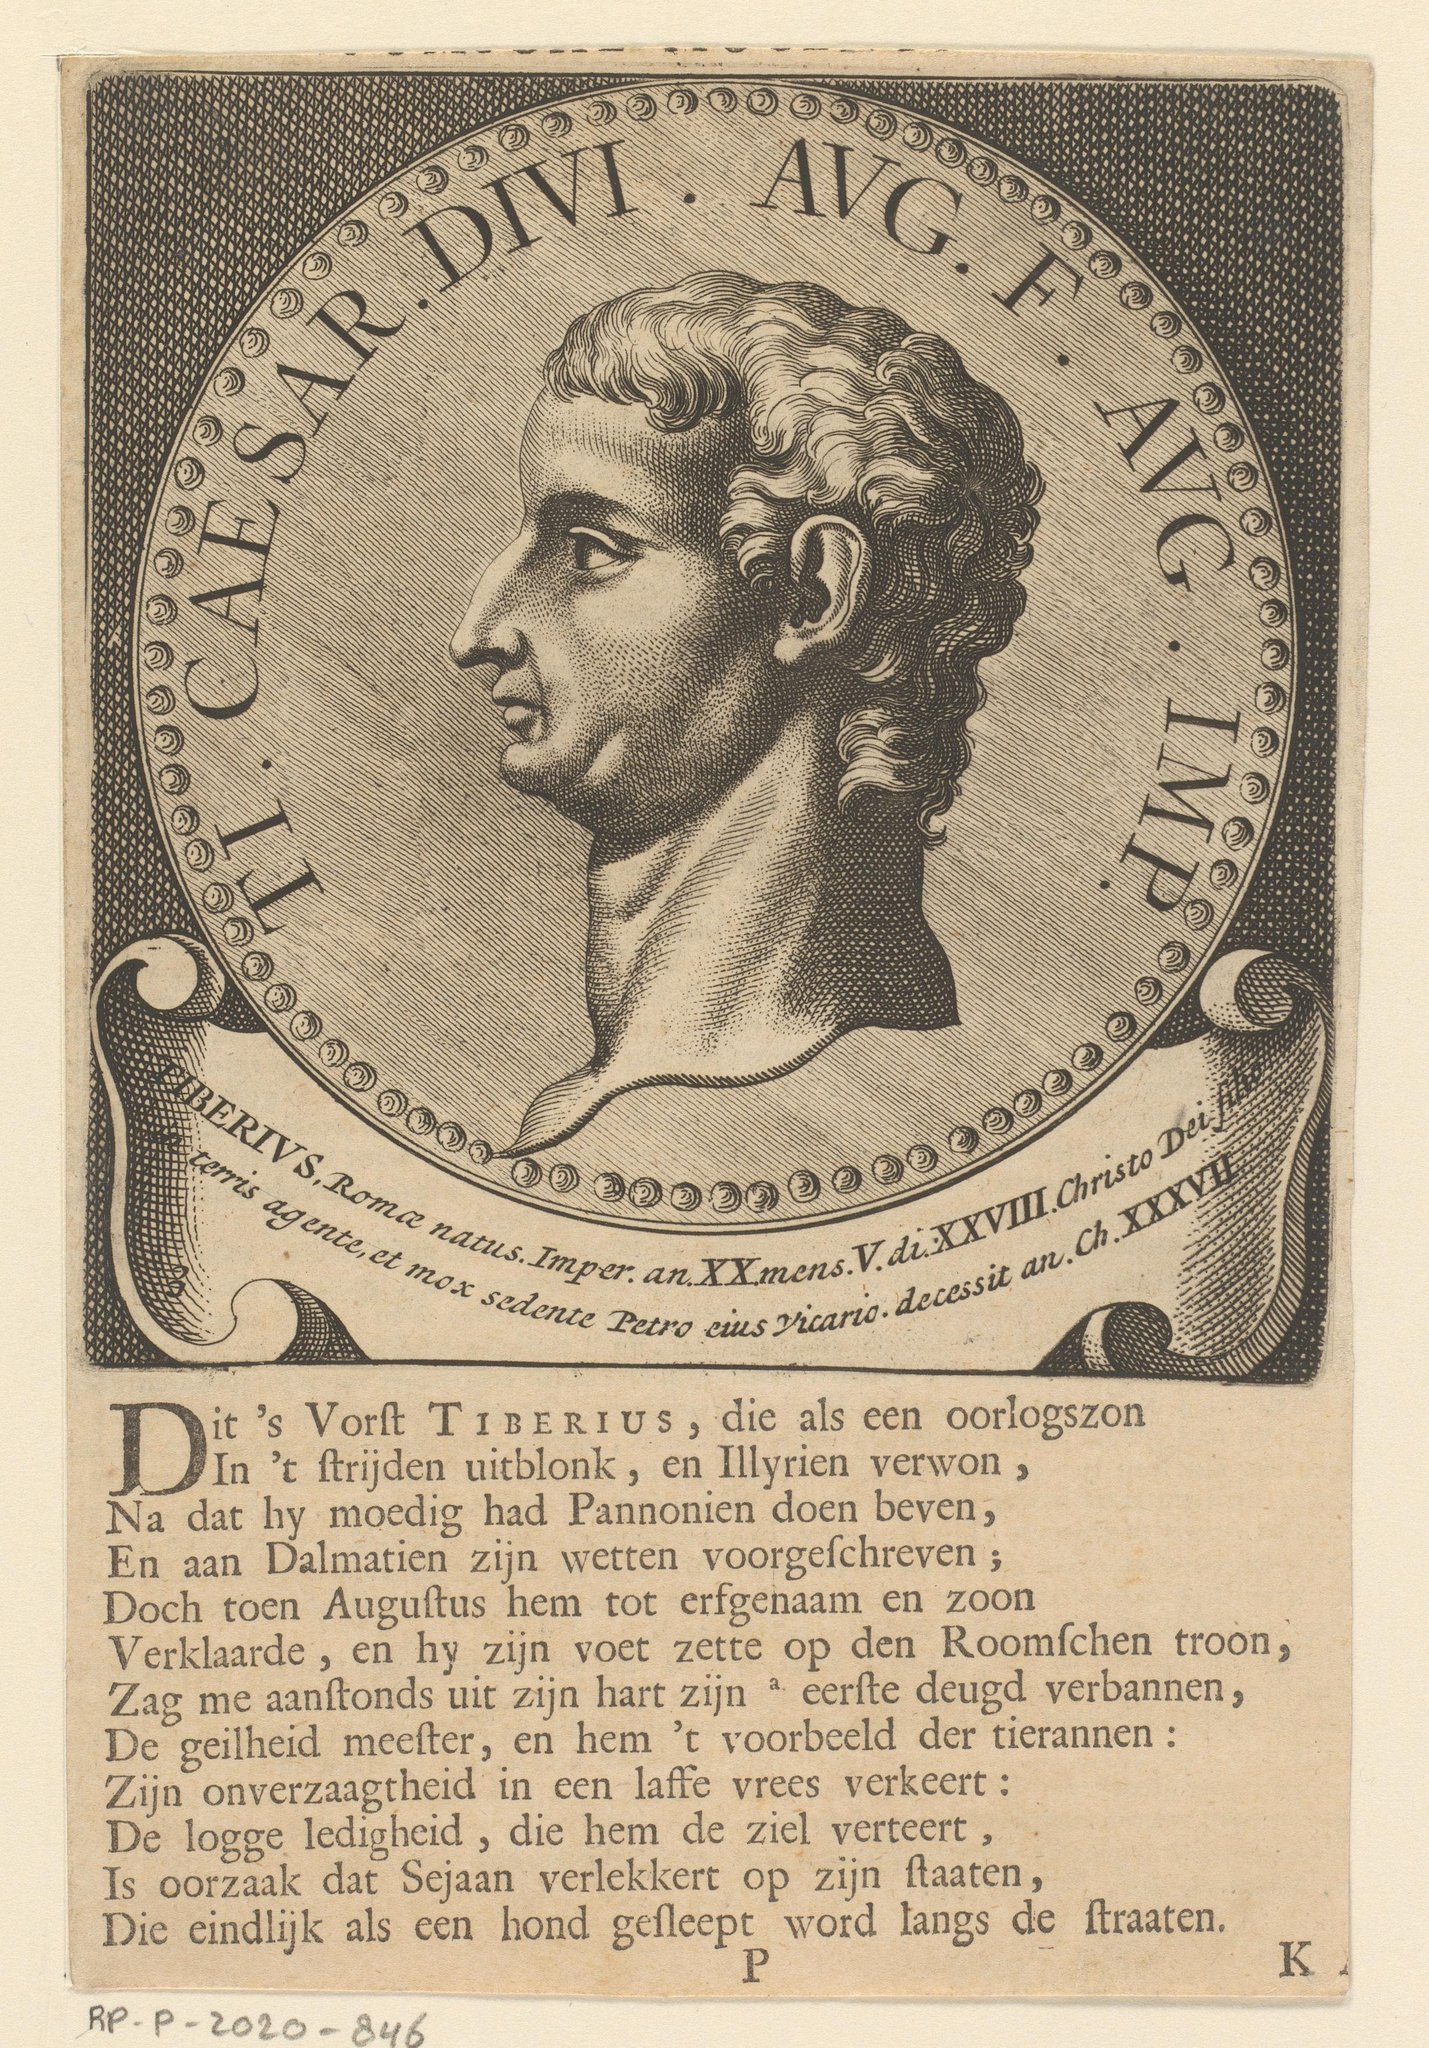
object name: print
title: Tiberius, Romae natus (...)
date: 1697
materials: paper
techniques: engraving, etching, letterpress printing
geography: utrecht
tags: miseno, historical persons, emperor, male persons from classical history (tiberius)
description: Prent uit: Bogaert, Abraham. De Roomsche monarchy, vertoont in de muntbeelden der westersche en oostersche keizeren (...). Utrecht: François Halma en Willem van de Water, 1697, p. 113. Eerste staat verschenen in een grotere prent met twaalf portretten, gedateerd 1695.